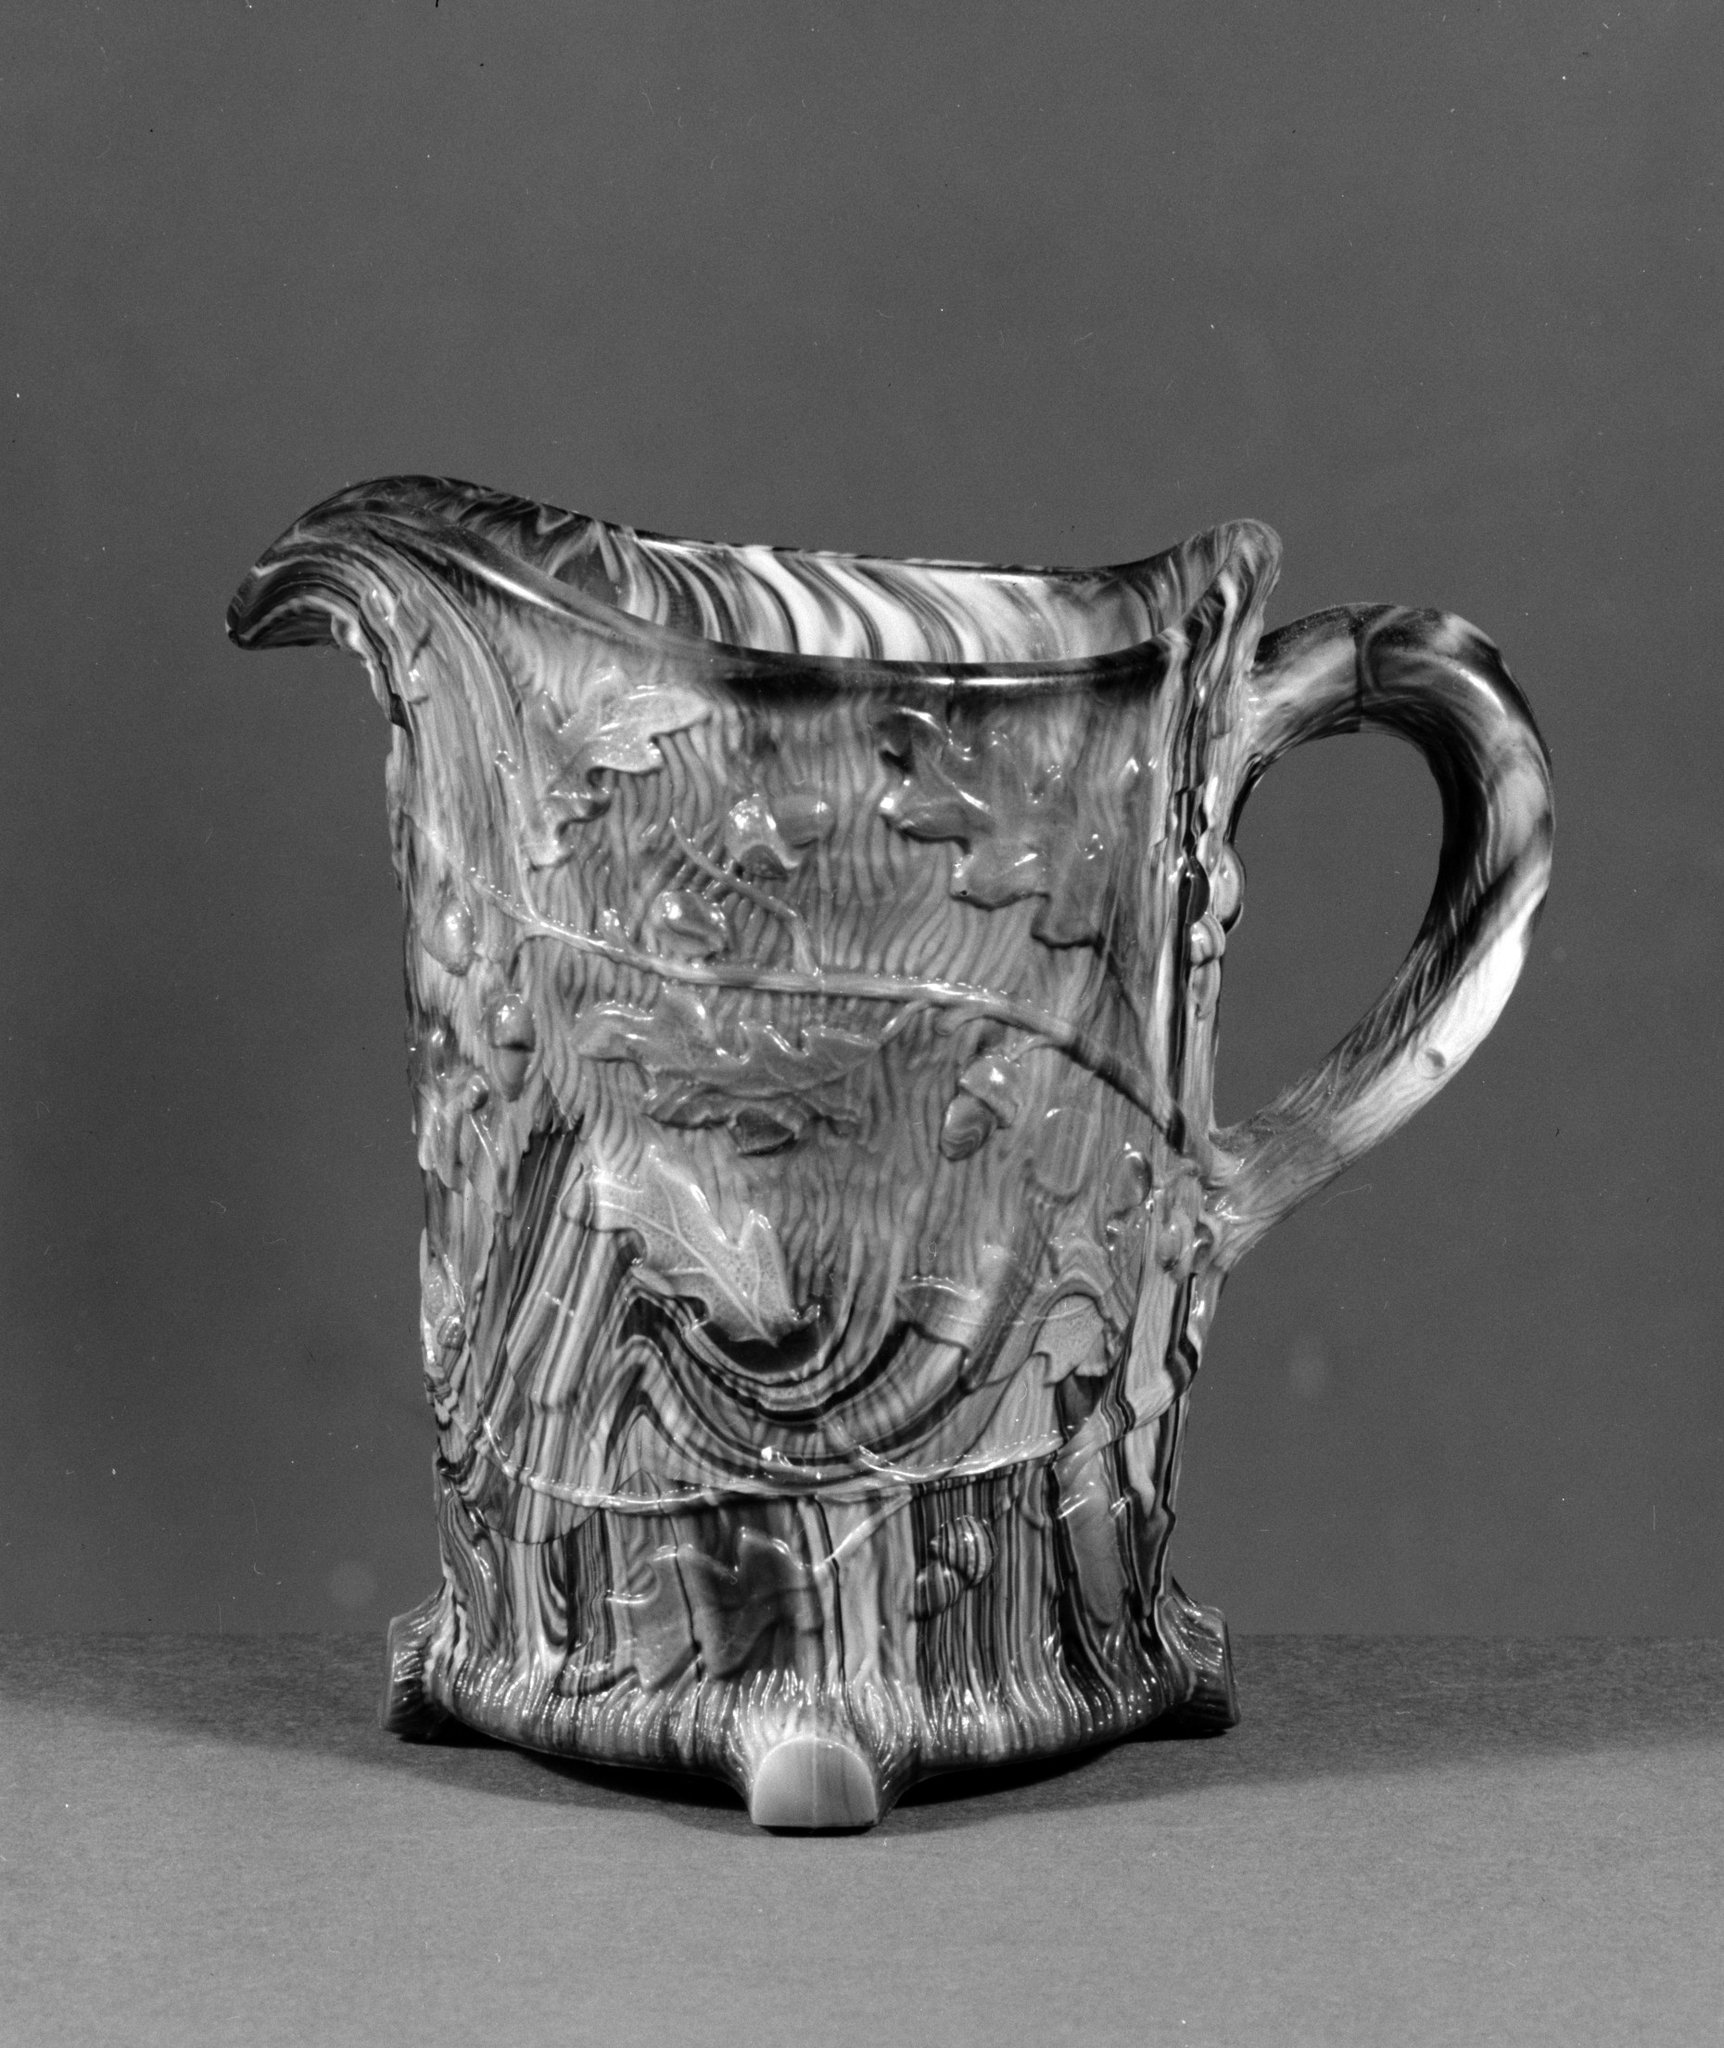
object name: cream pot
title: Creamer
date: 1850-1900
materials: glass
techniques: pressed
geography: england